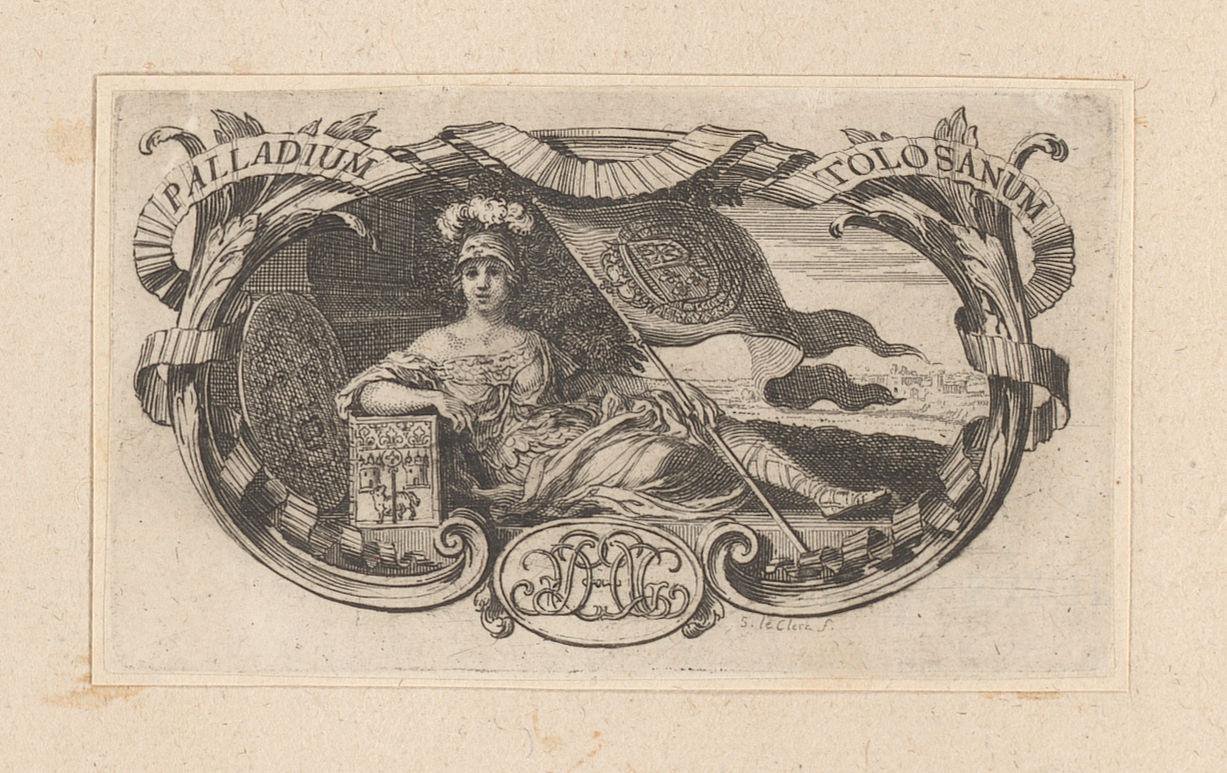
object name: album leaf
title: Vignet met Minerva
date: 1687-1701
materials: paper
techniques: etching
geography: toulouse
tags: (story of) minerva (pallas, athena), vignette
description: Prent gebruikt voor: La Faille, Germain de. Annales de la ville de Toulouse depuis la réunion de la Comté de Toulouse à la couronne (...). Toulouse: Guillaume-Louis Colomyez en Jérôme Posuel, 1687-1701.